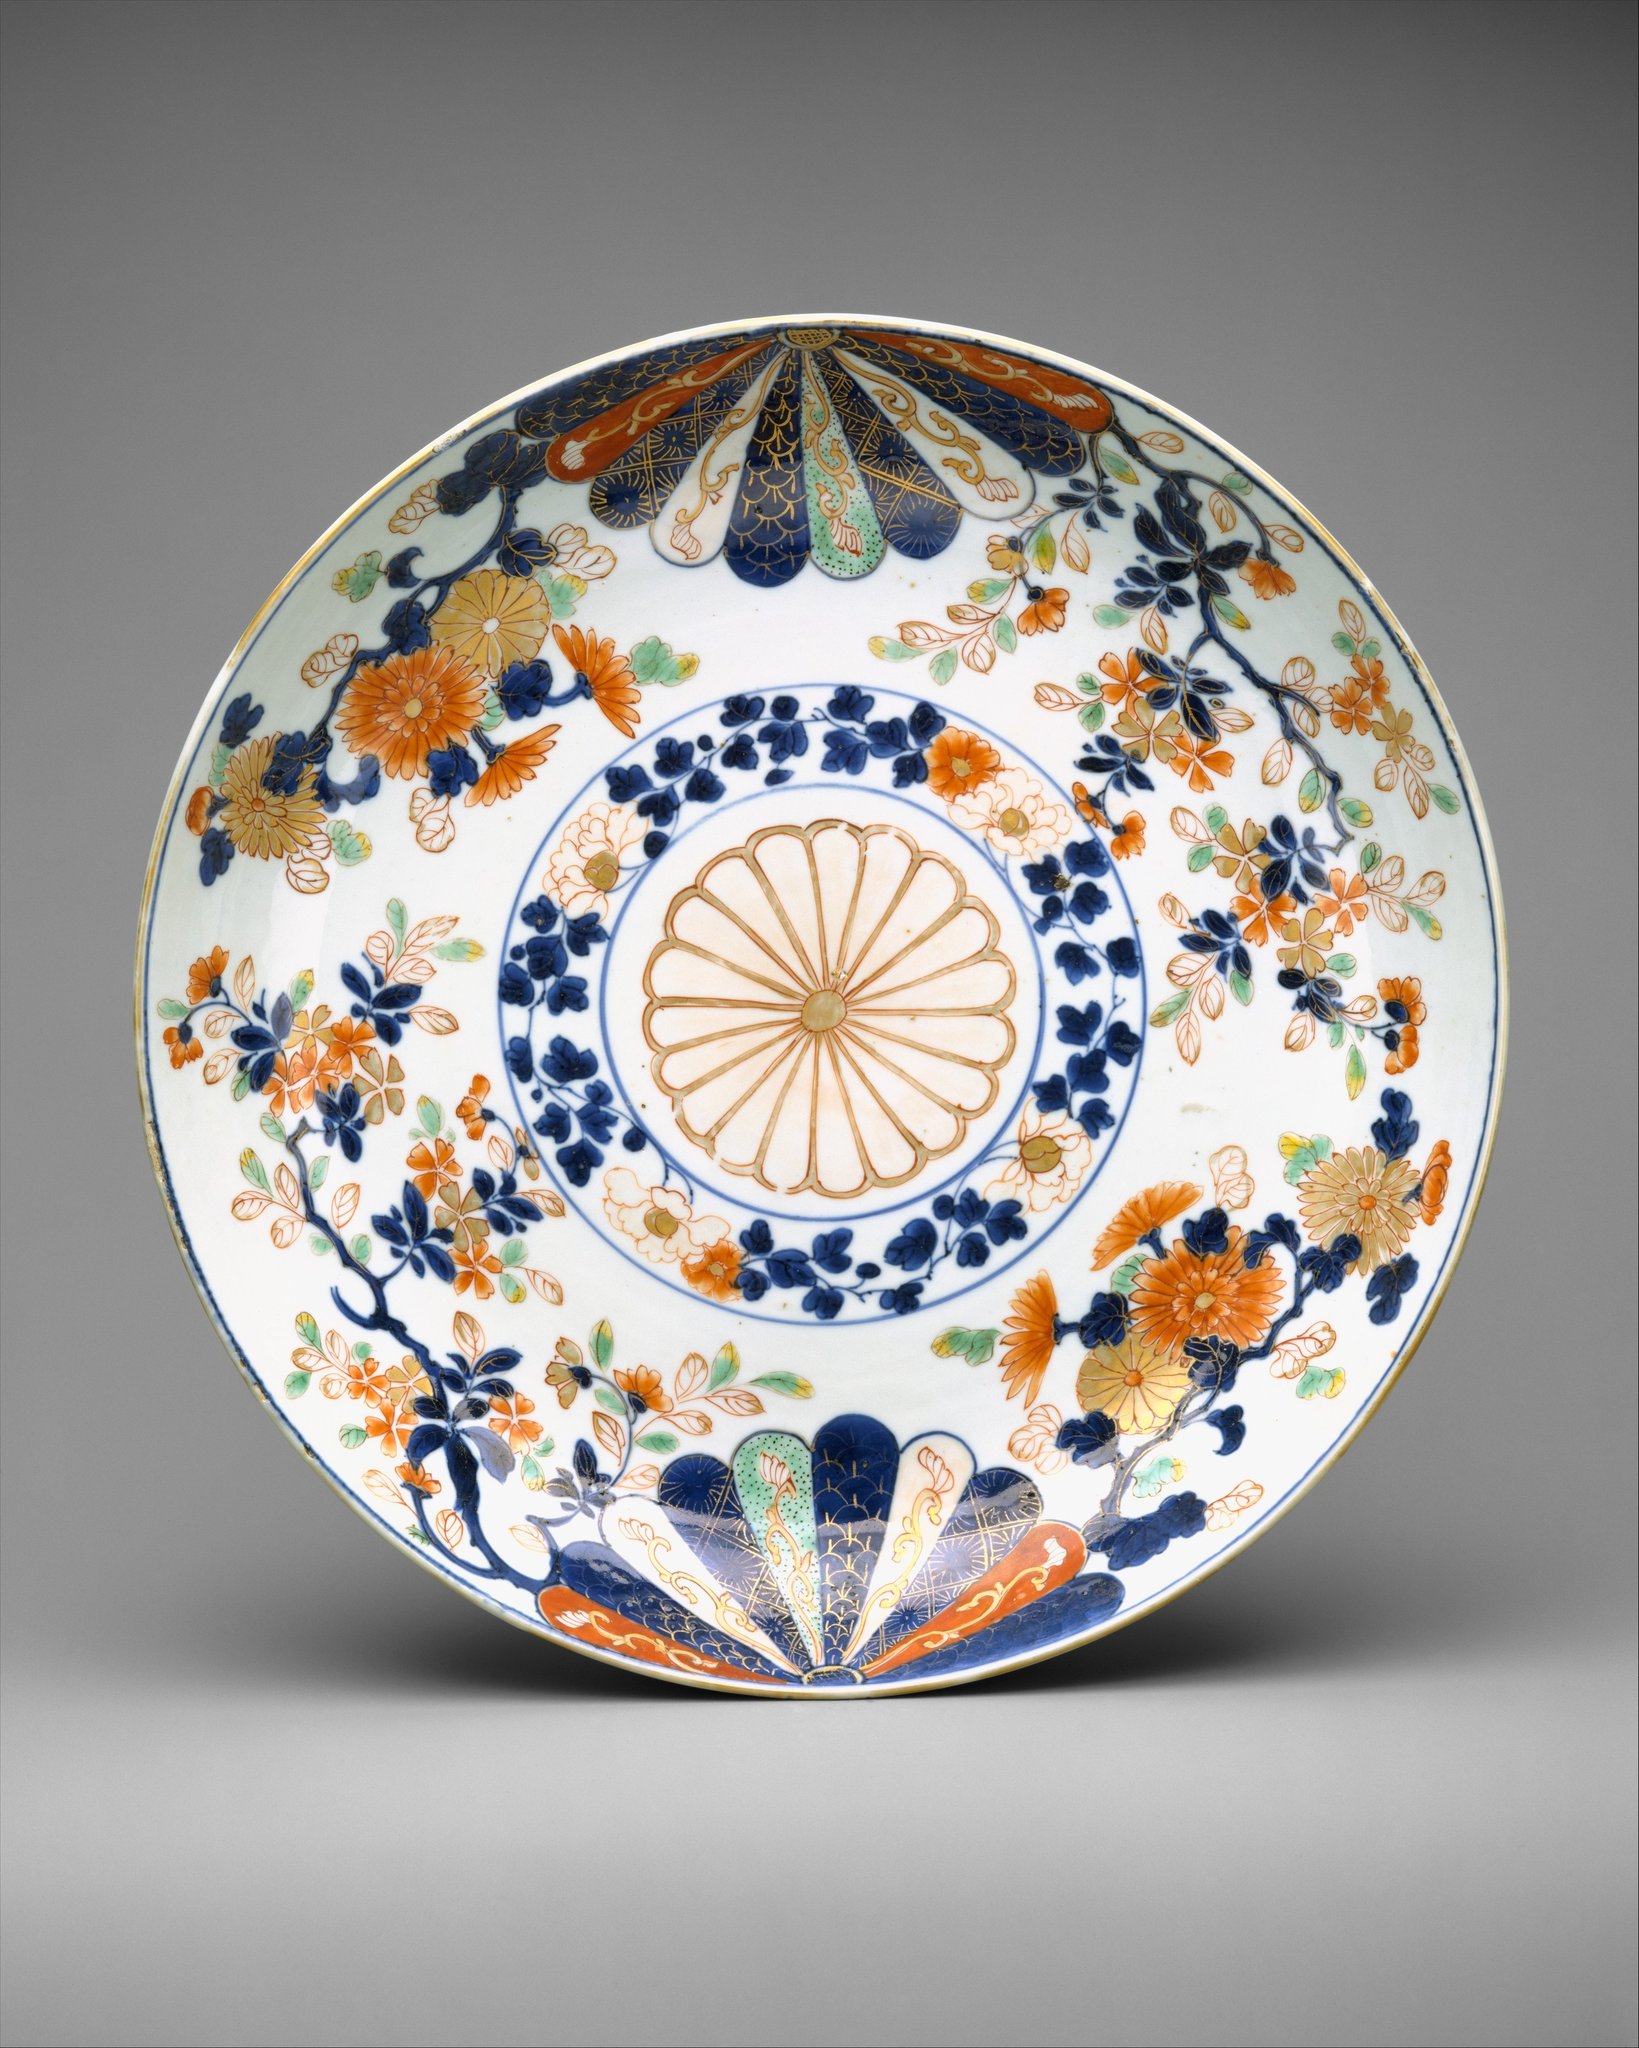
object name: dish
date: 1700-1725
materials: hard paste porcelain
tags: flowers